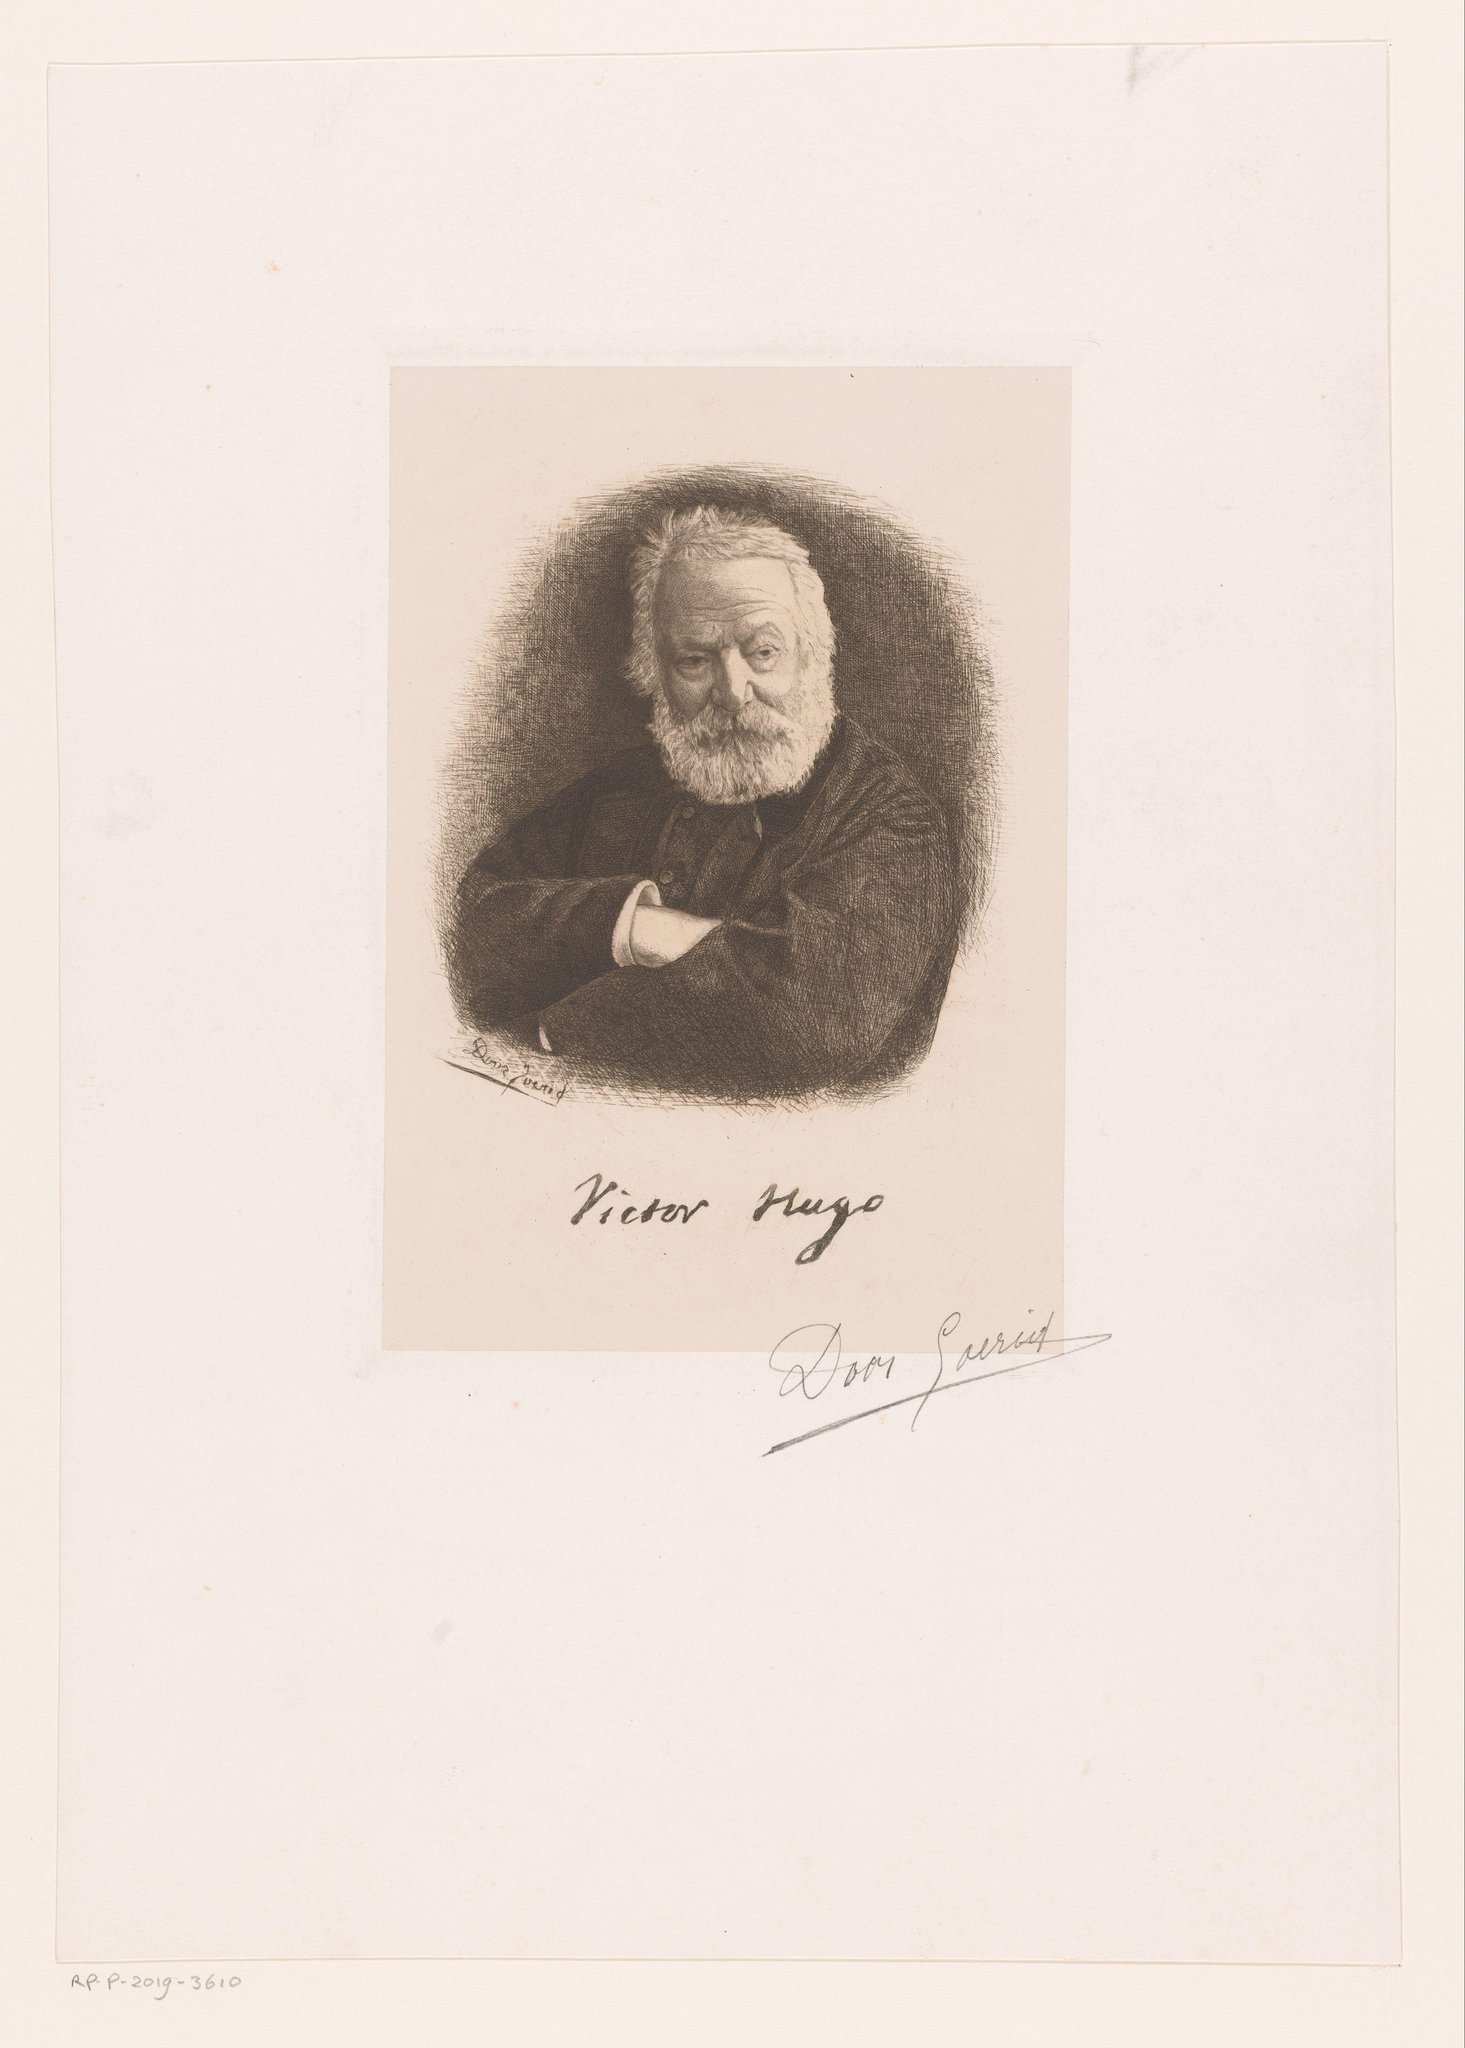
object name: print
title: Victor Hugo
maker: david goerig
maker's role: print maker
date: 1850-1899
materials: paper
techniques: etching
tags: paris, victor hugo, historical persons, old man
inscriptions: collector's mark: Lugt 2228